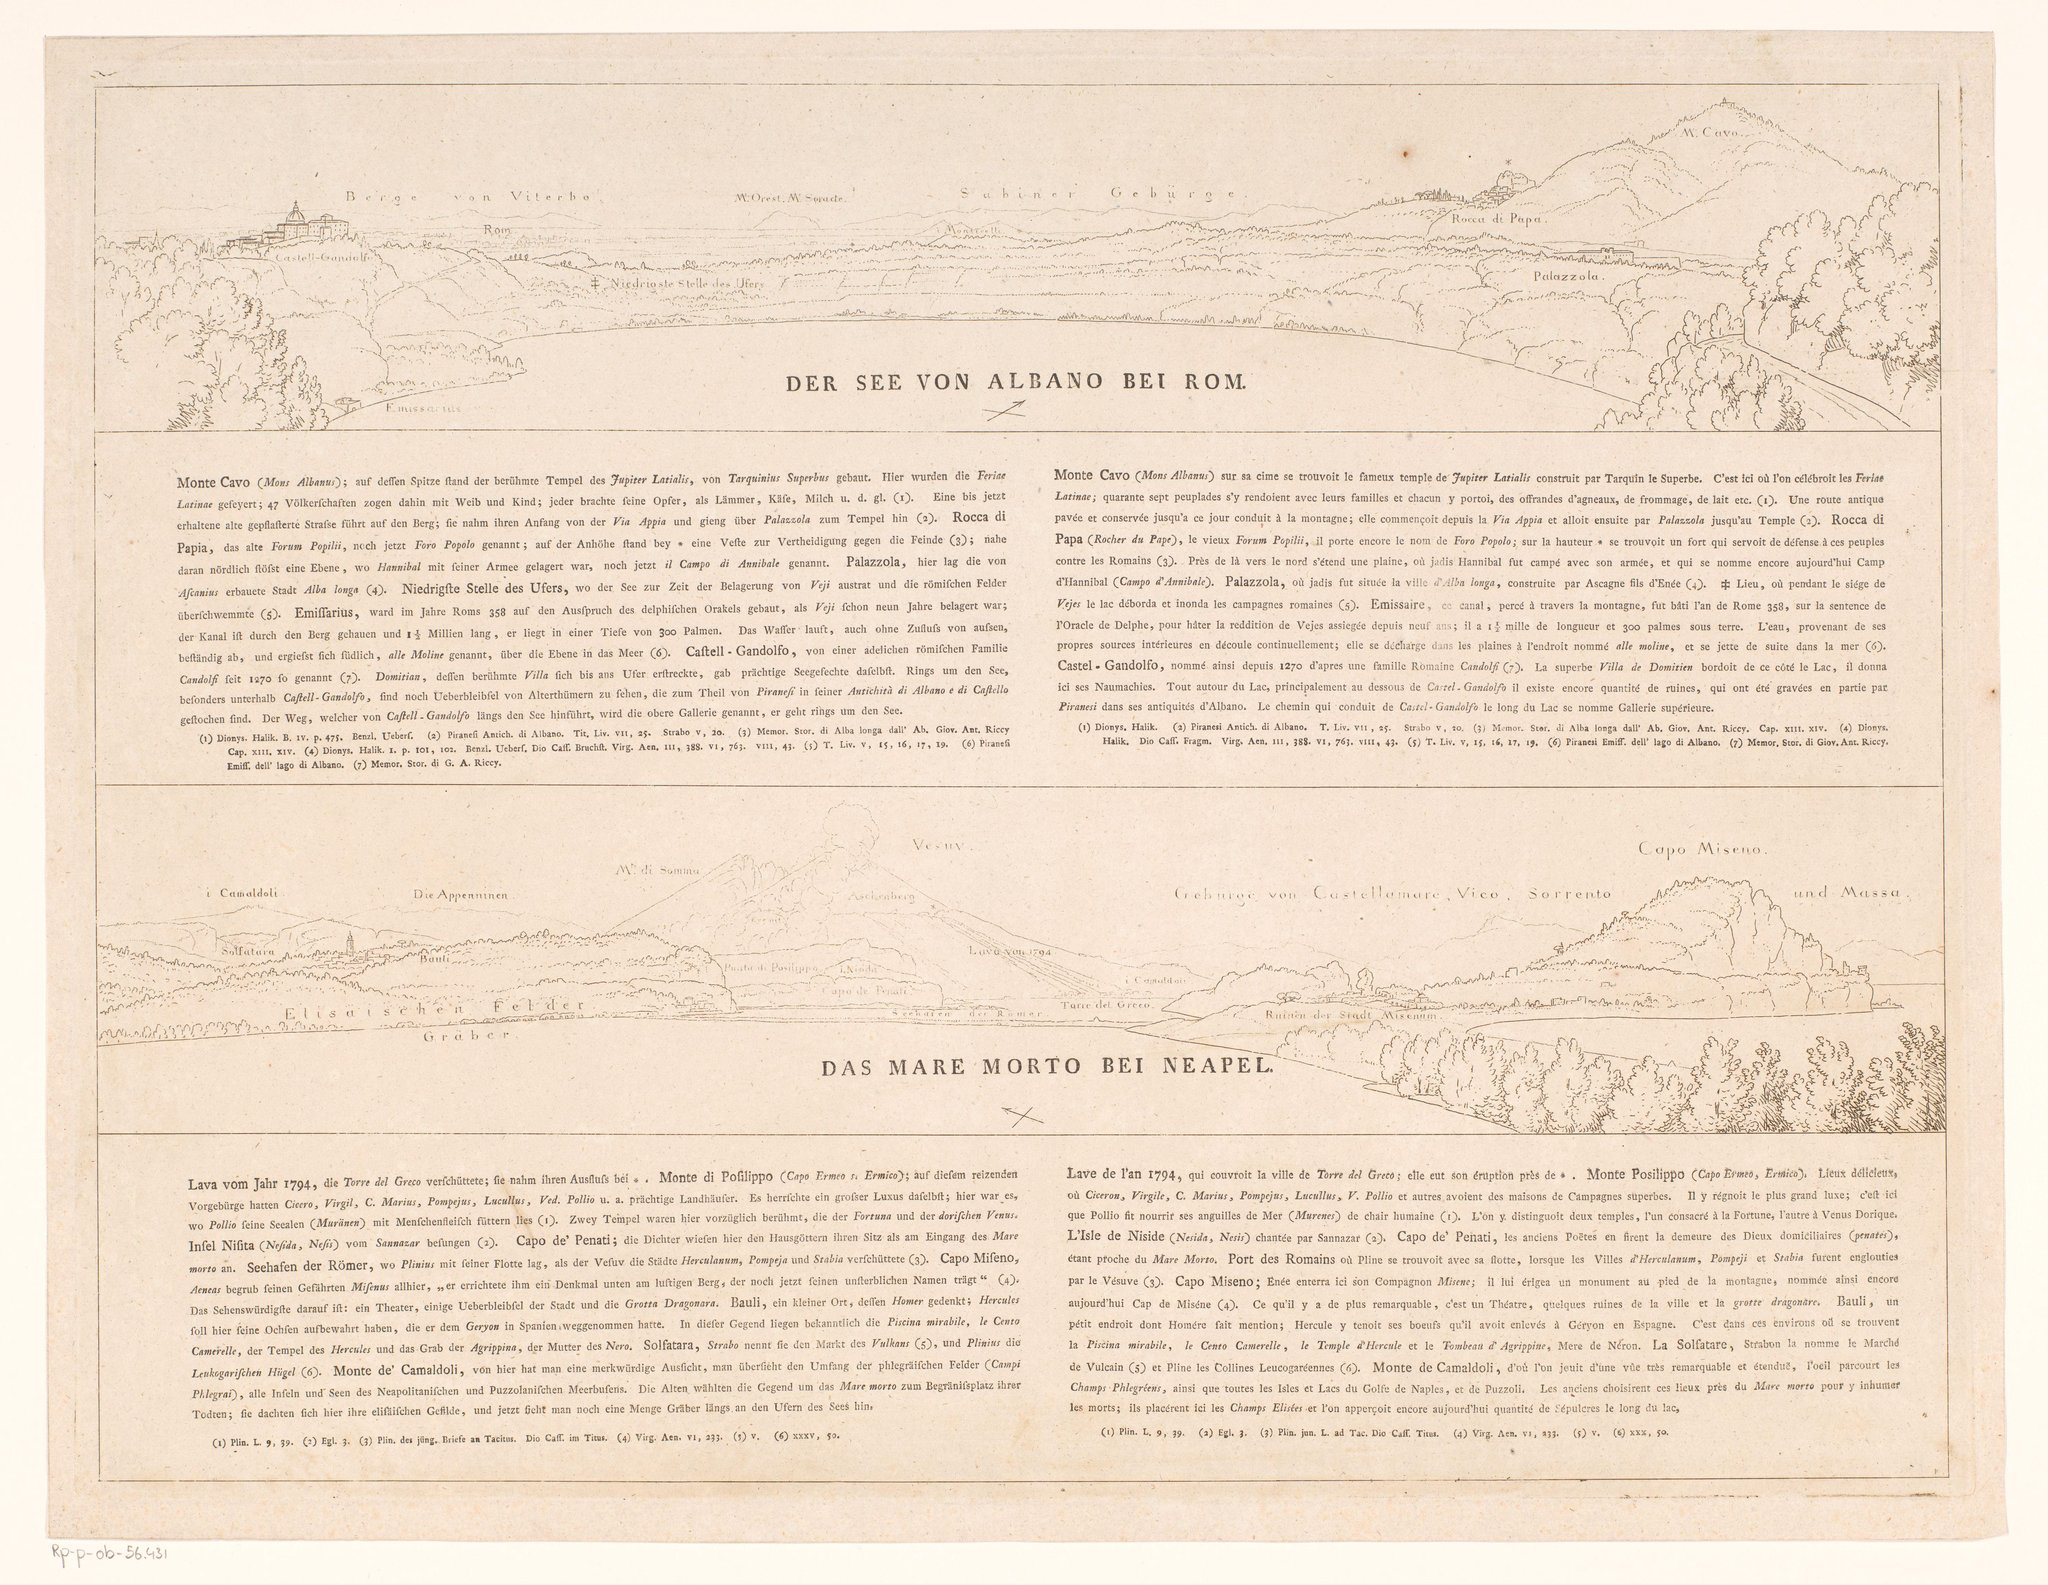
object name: print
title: Tekstblad met aanzichten van het Meer van Albano en de Mare Morto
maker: wilhelm friedrich gmelin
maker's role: print maker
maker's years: 1760-1820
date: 1770-1820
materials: paper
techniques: etching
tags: maps, atlases, naples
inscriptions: collector's mark: Lugt 2228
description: In de schematische aanzichten staan de belangrijkste plaatsen vermeld. Onder de gezichten is in een uitgebreide tekst informatie over de meren te lezen.